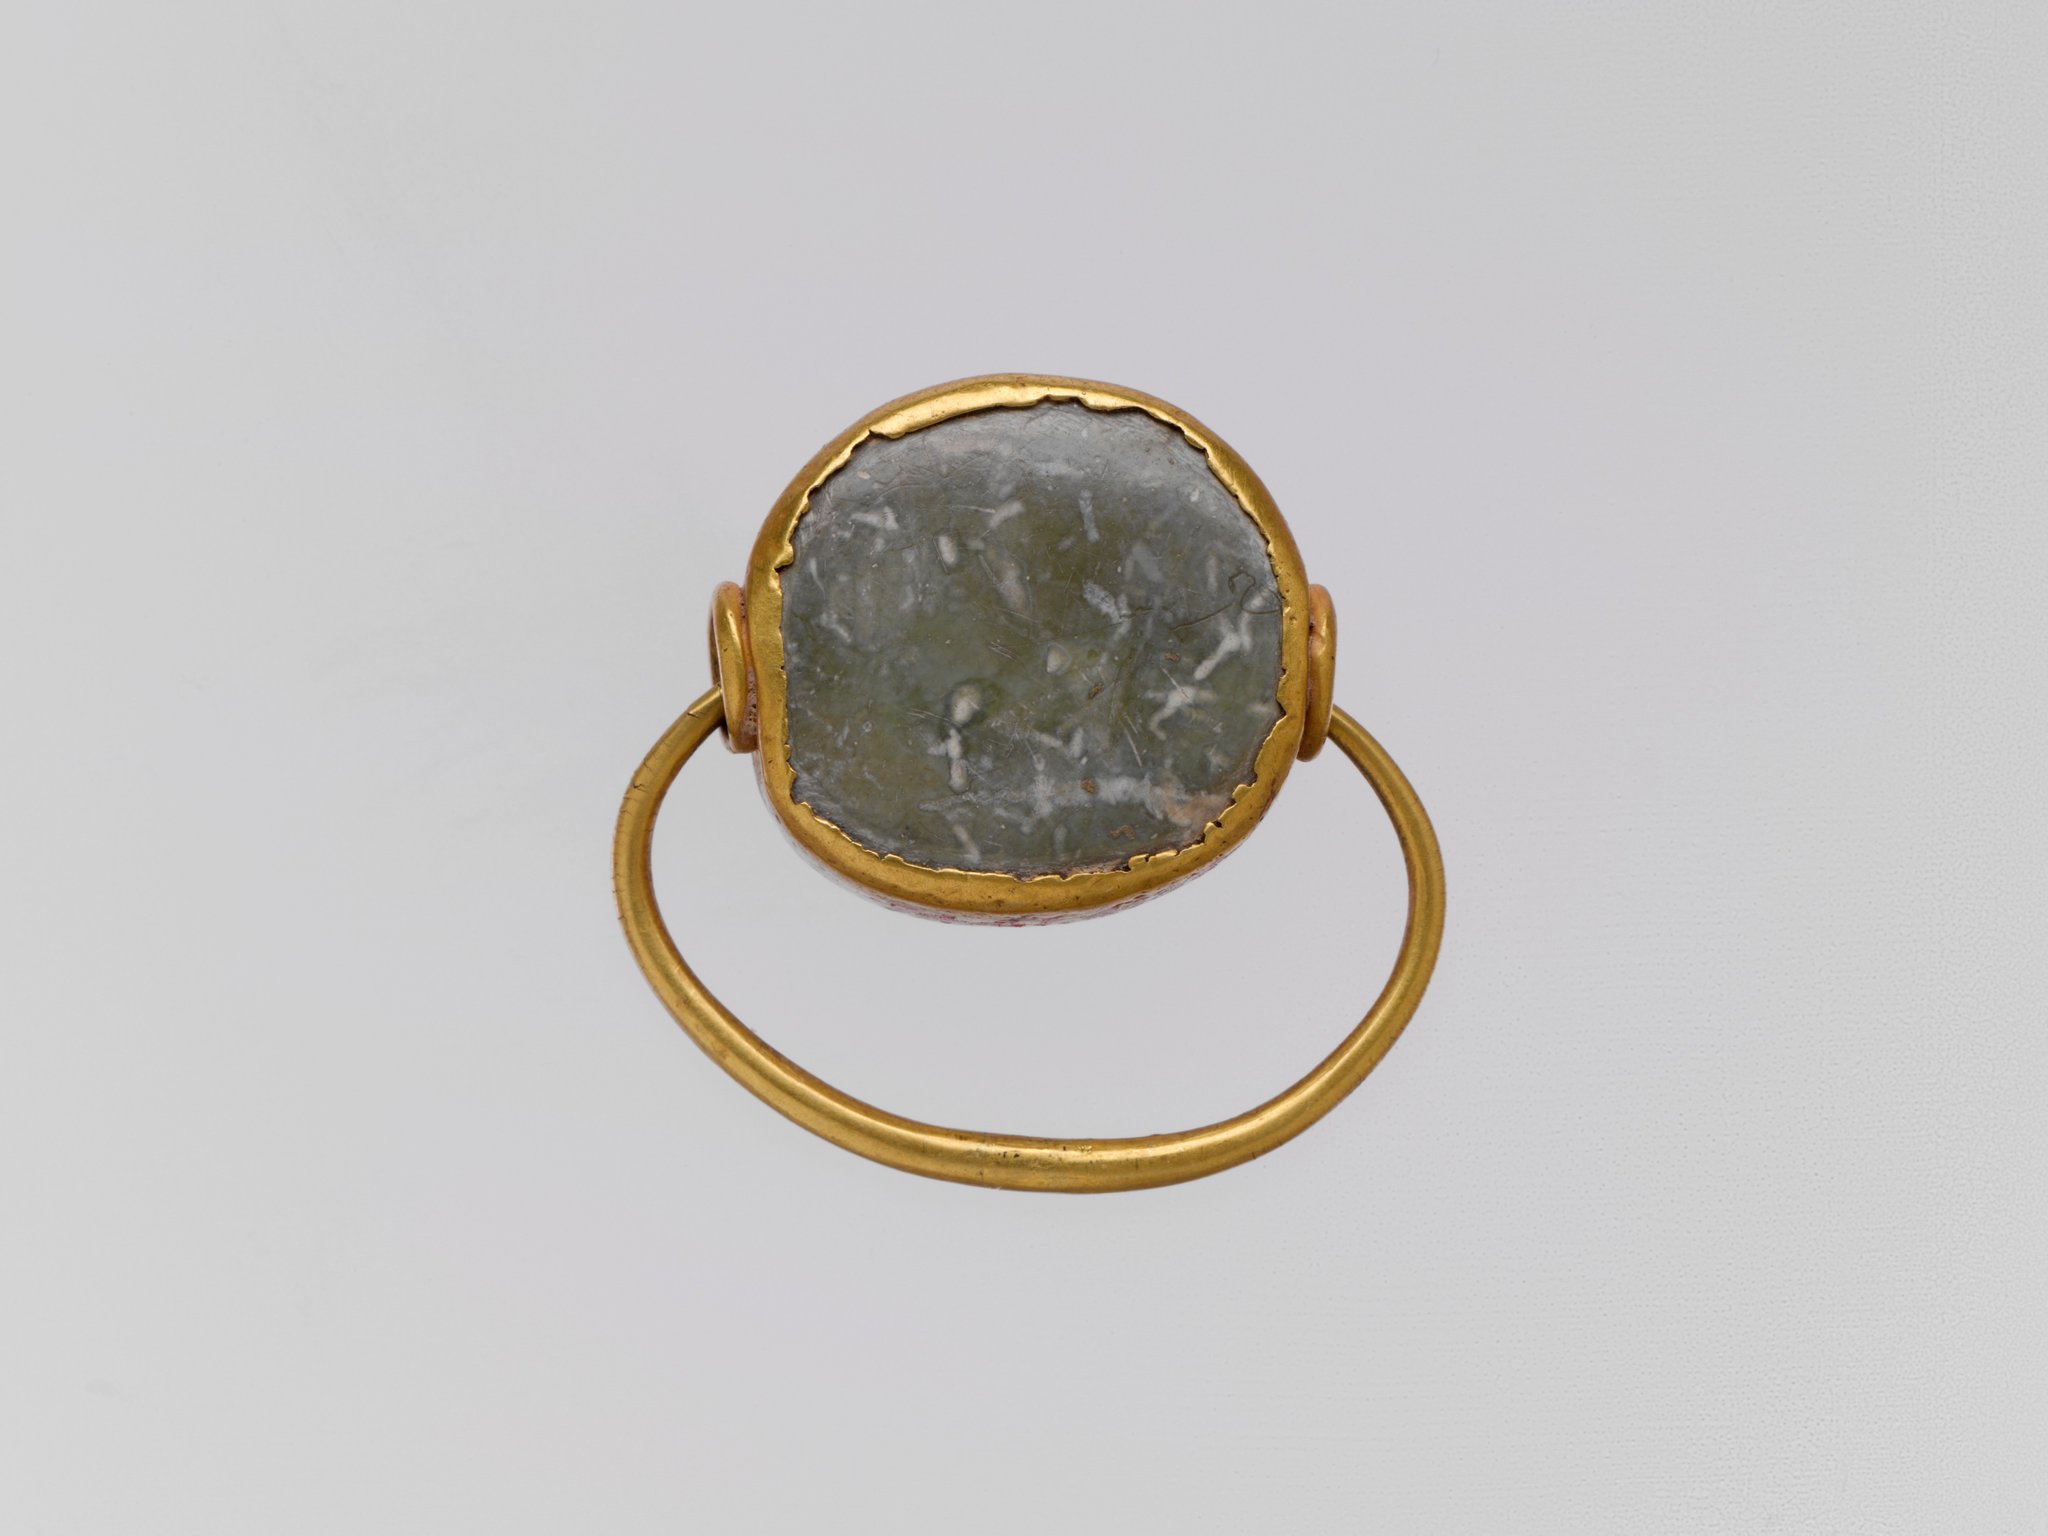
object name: ring with bead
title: Gold hoop with picrolite stone in gold setting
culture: cypriot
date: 600-401 BCE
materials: gold, stone